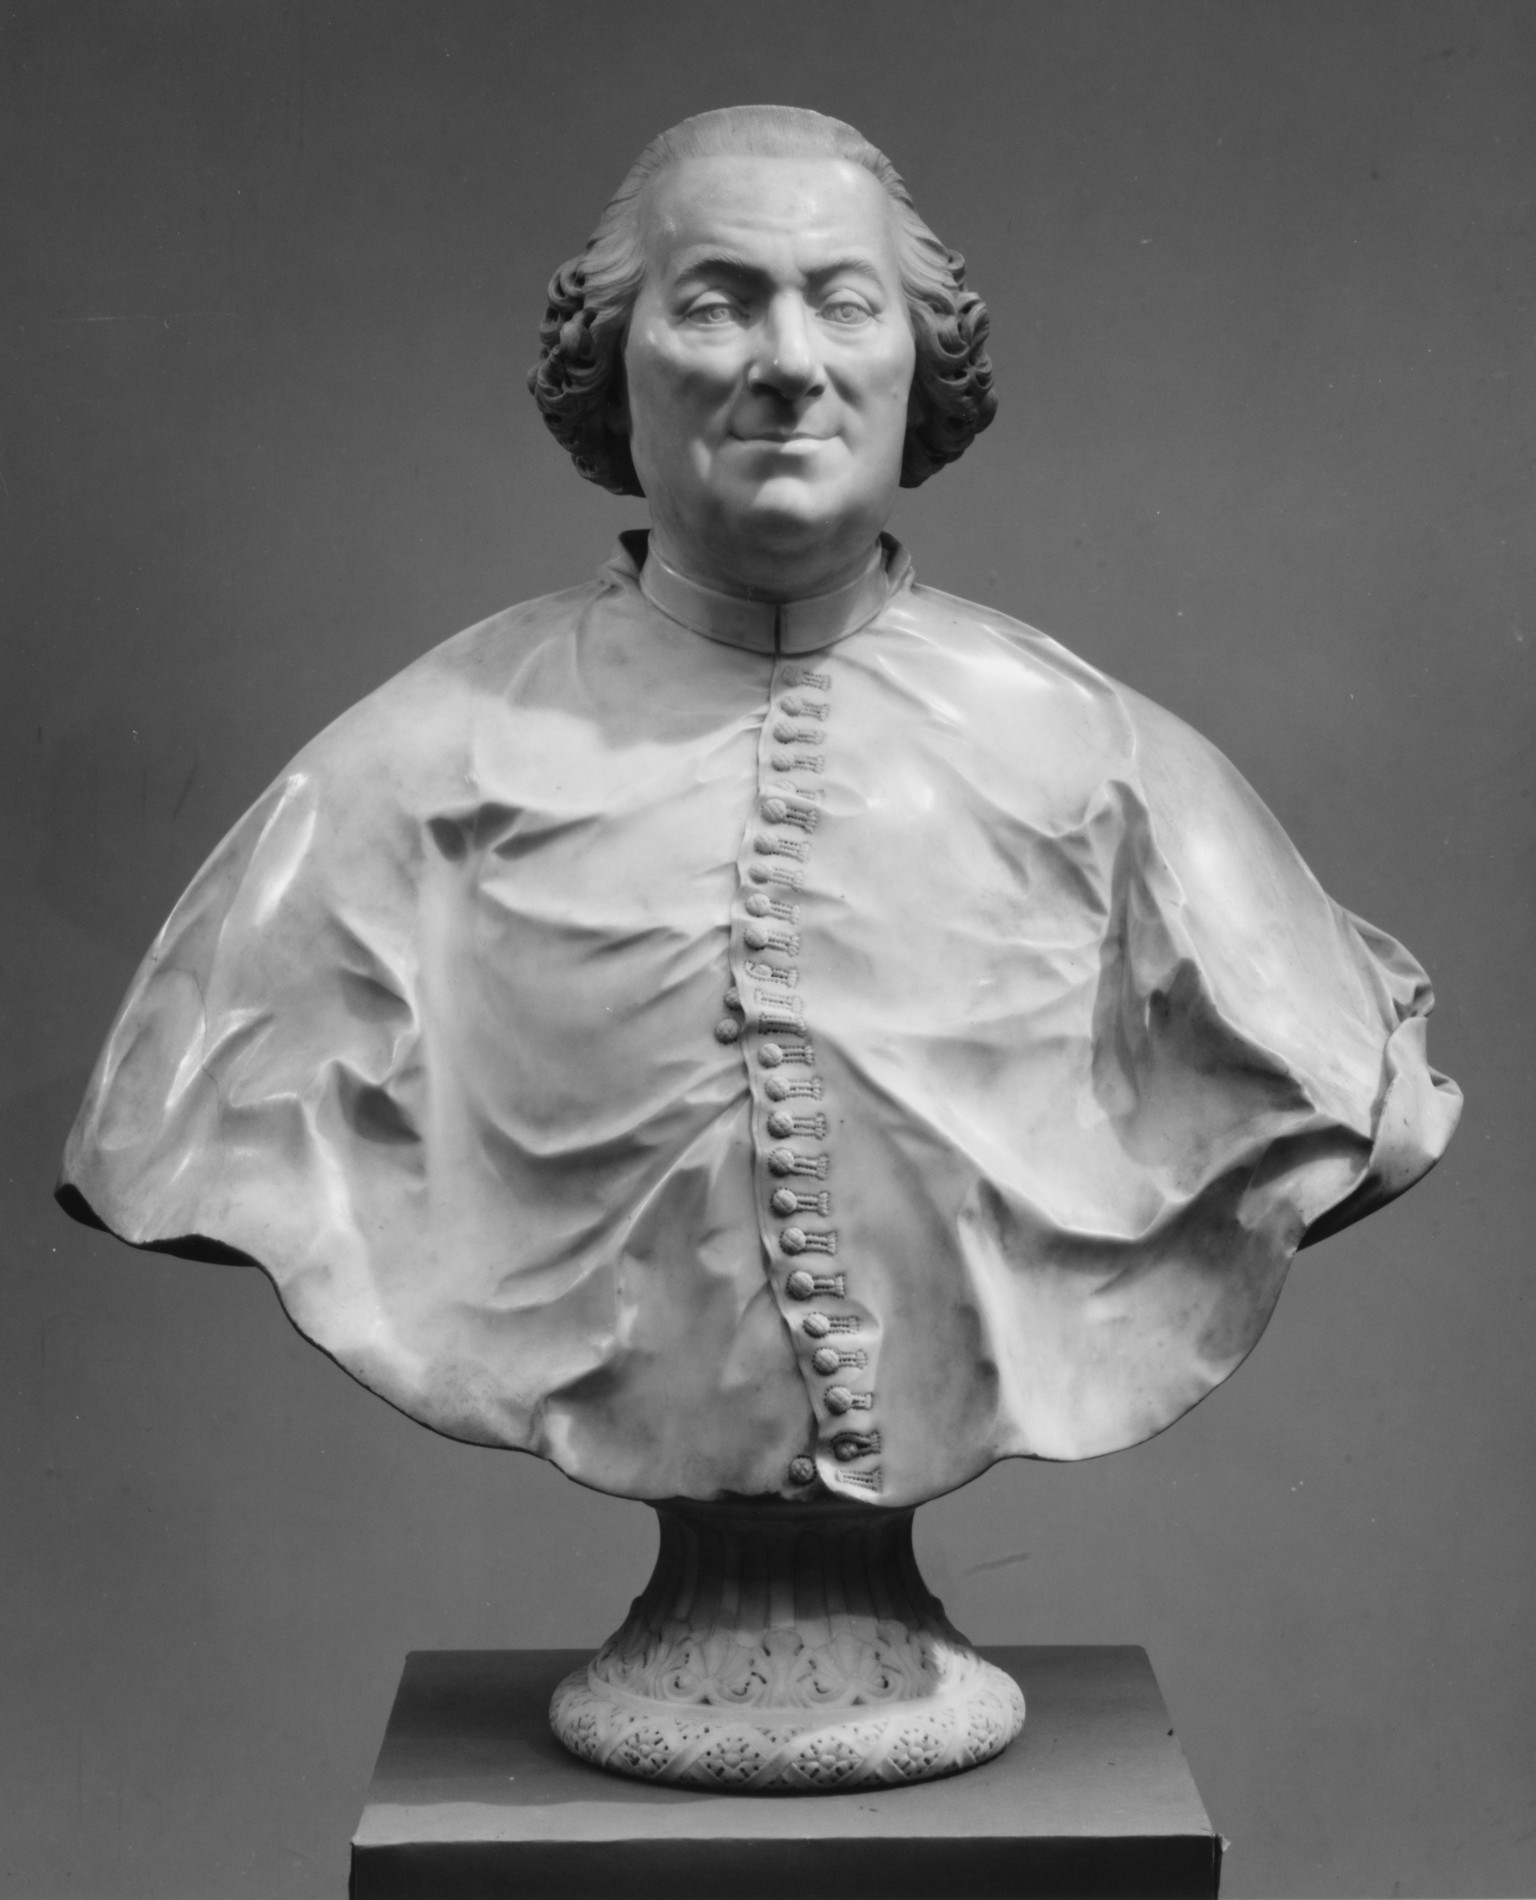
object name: bust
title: Cardinal Giuseppe Maria Feroni (1699–1767)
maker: andré jean lebrun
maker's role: artist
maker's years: 1737-1811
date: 1767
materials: marble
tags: men,portraits